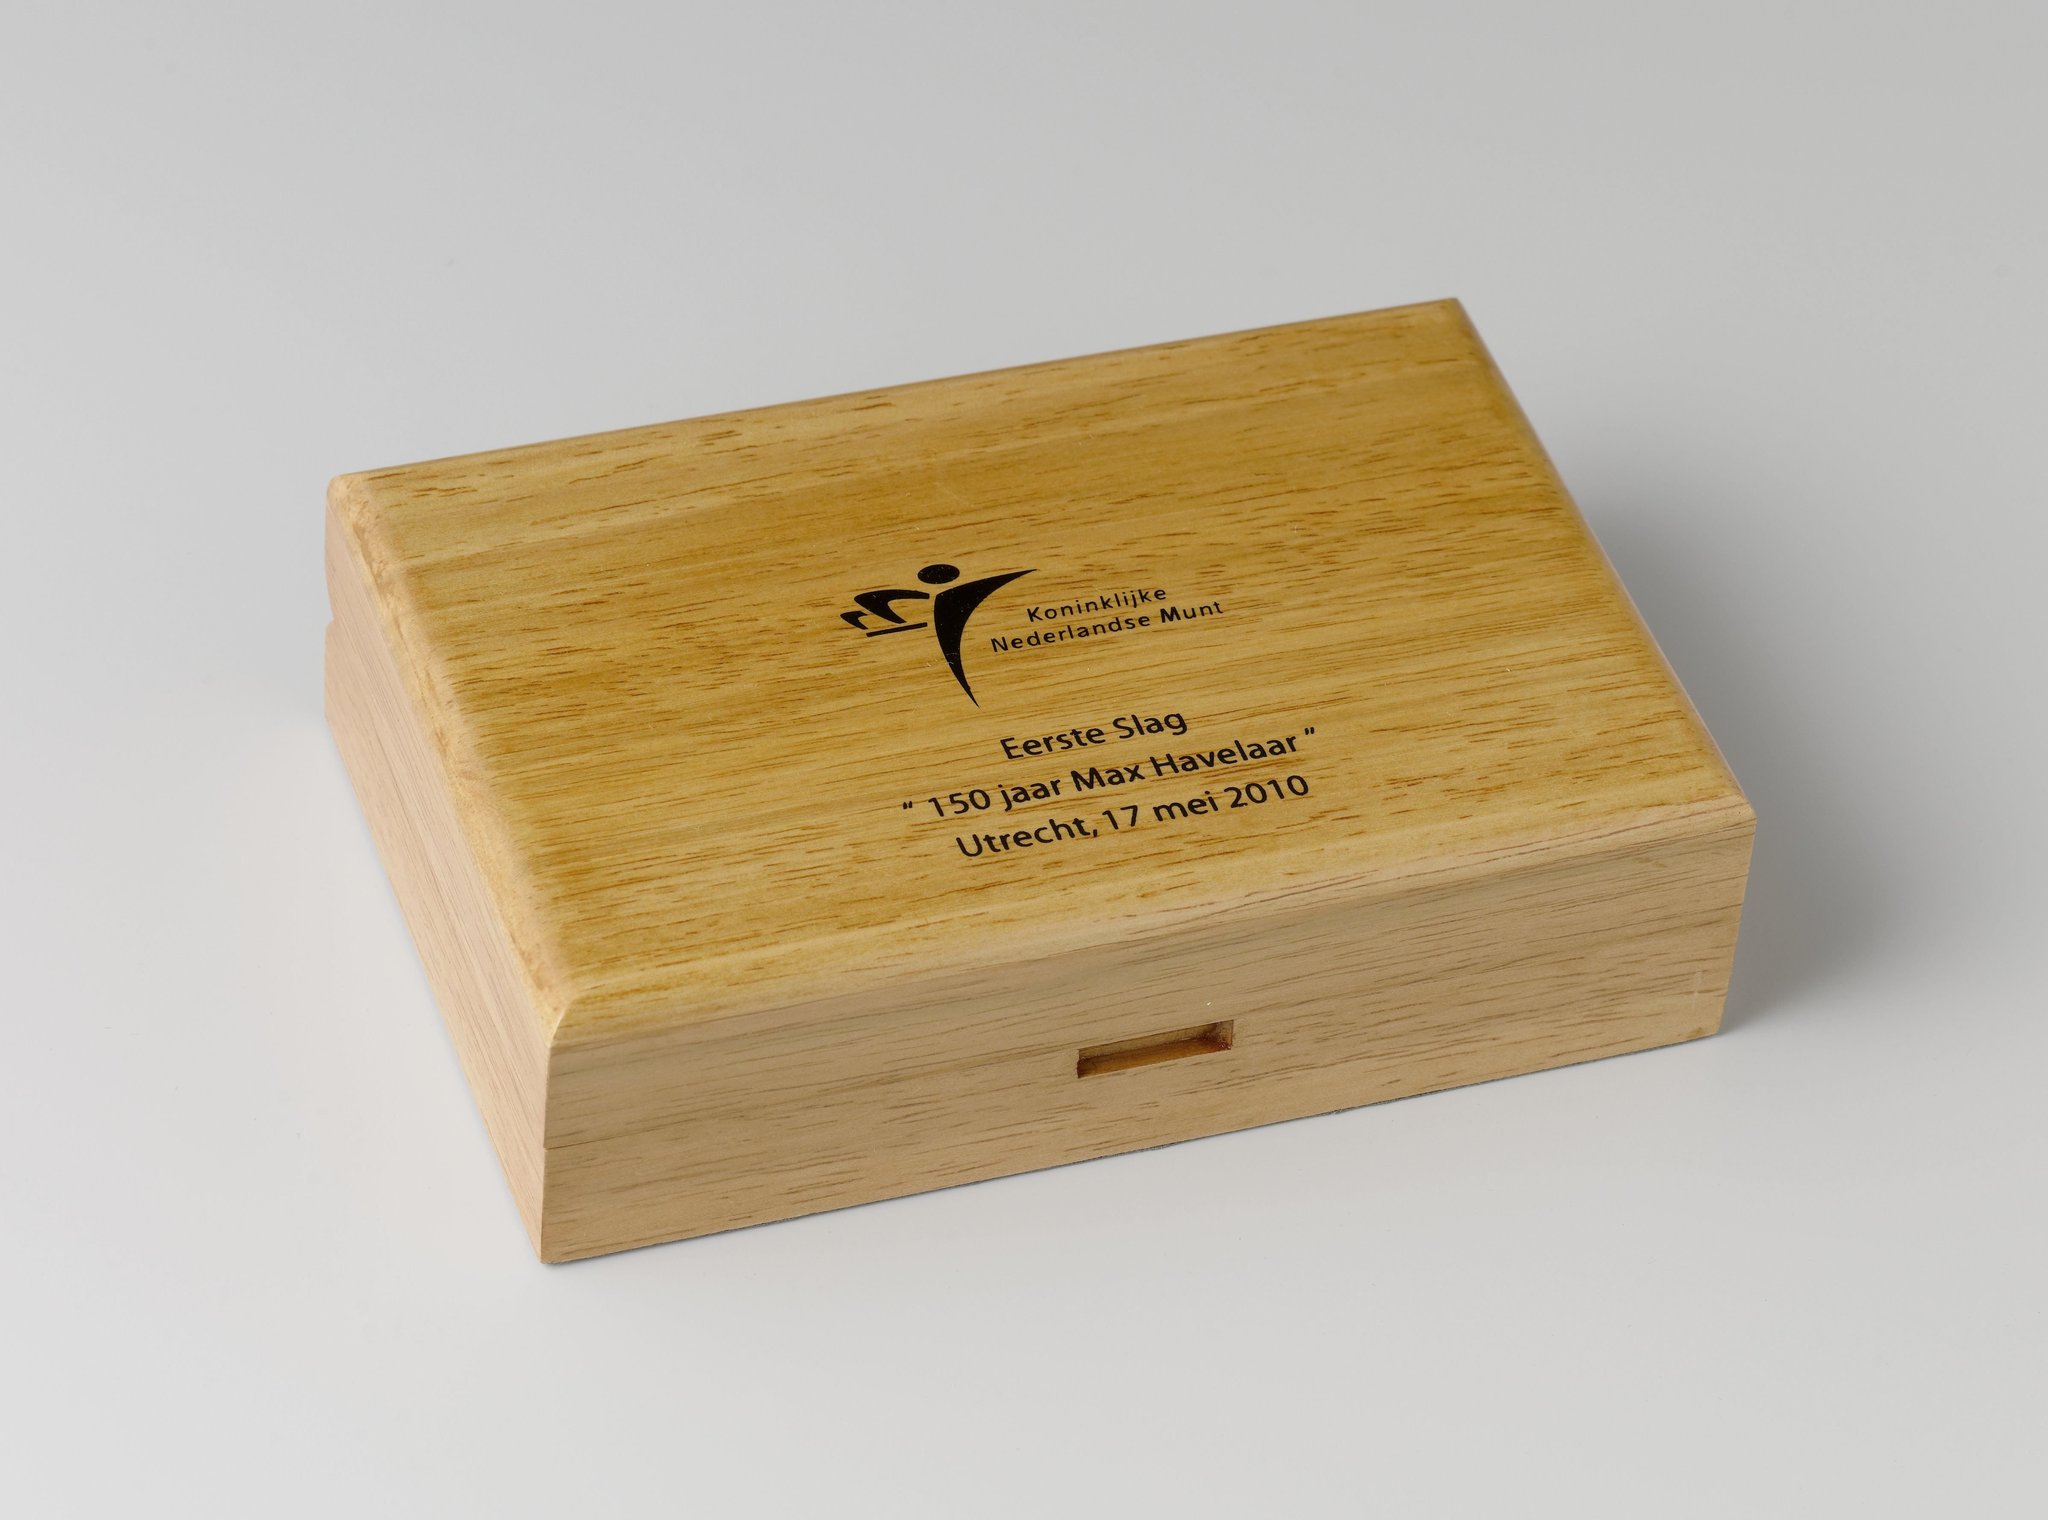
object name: box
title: Houten doos bij munt '150 jaar Max Havelaar'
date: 2010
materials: paper, velvet, wood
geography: utrecht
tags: multatuli, netherlands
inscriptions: inscription: ‘Eerste slag / '150 jaar Max Havelaar' / Utrecht, 17 mei 2010’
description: Houten doosje met opschrift en het logo van de Koninklijke Nederlandse Munt. Binnenzijde bekleed met blauw fluweel met uitsparing voor de munt. Aan de binnenzijde van het deksel is een los papiertje aangebracht met uitleg over de munt.